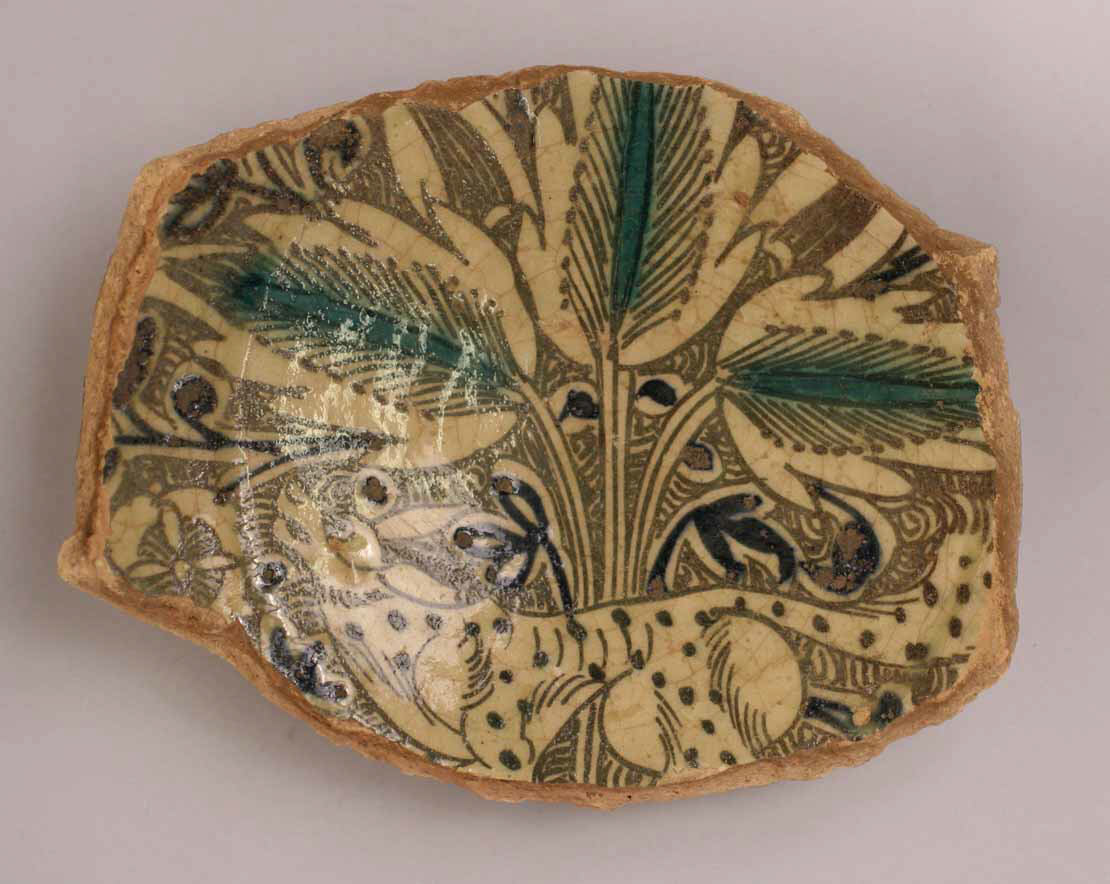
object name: fragment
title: Ceramic Fragment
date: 901-1200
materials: glaze, stonepaste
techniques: painting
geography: egypt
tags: animals,leaves